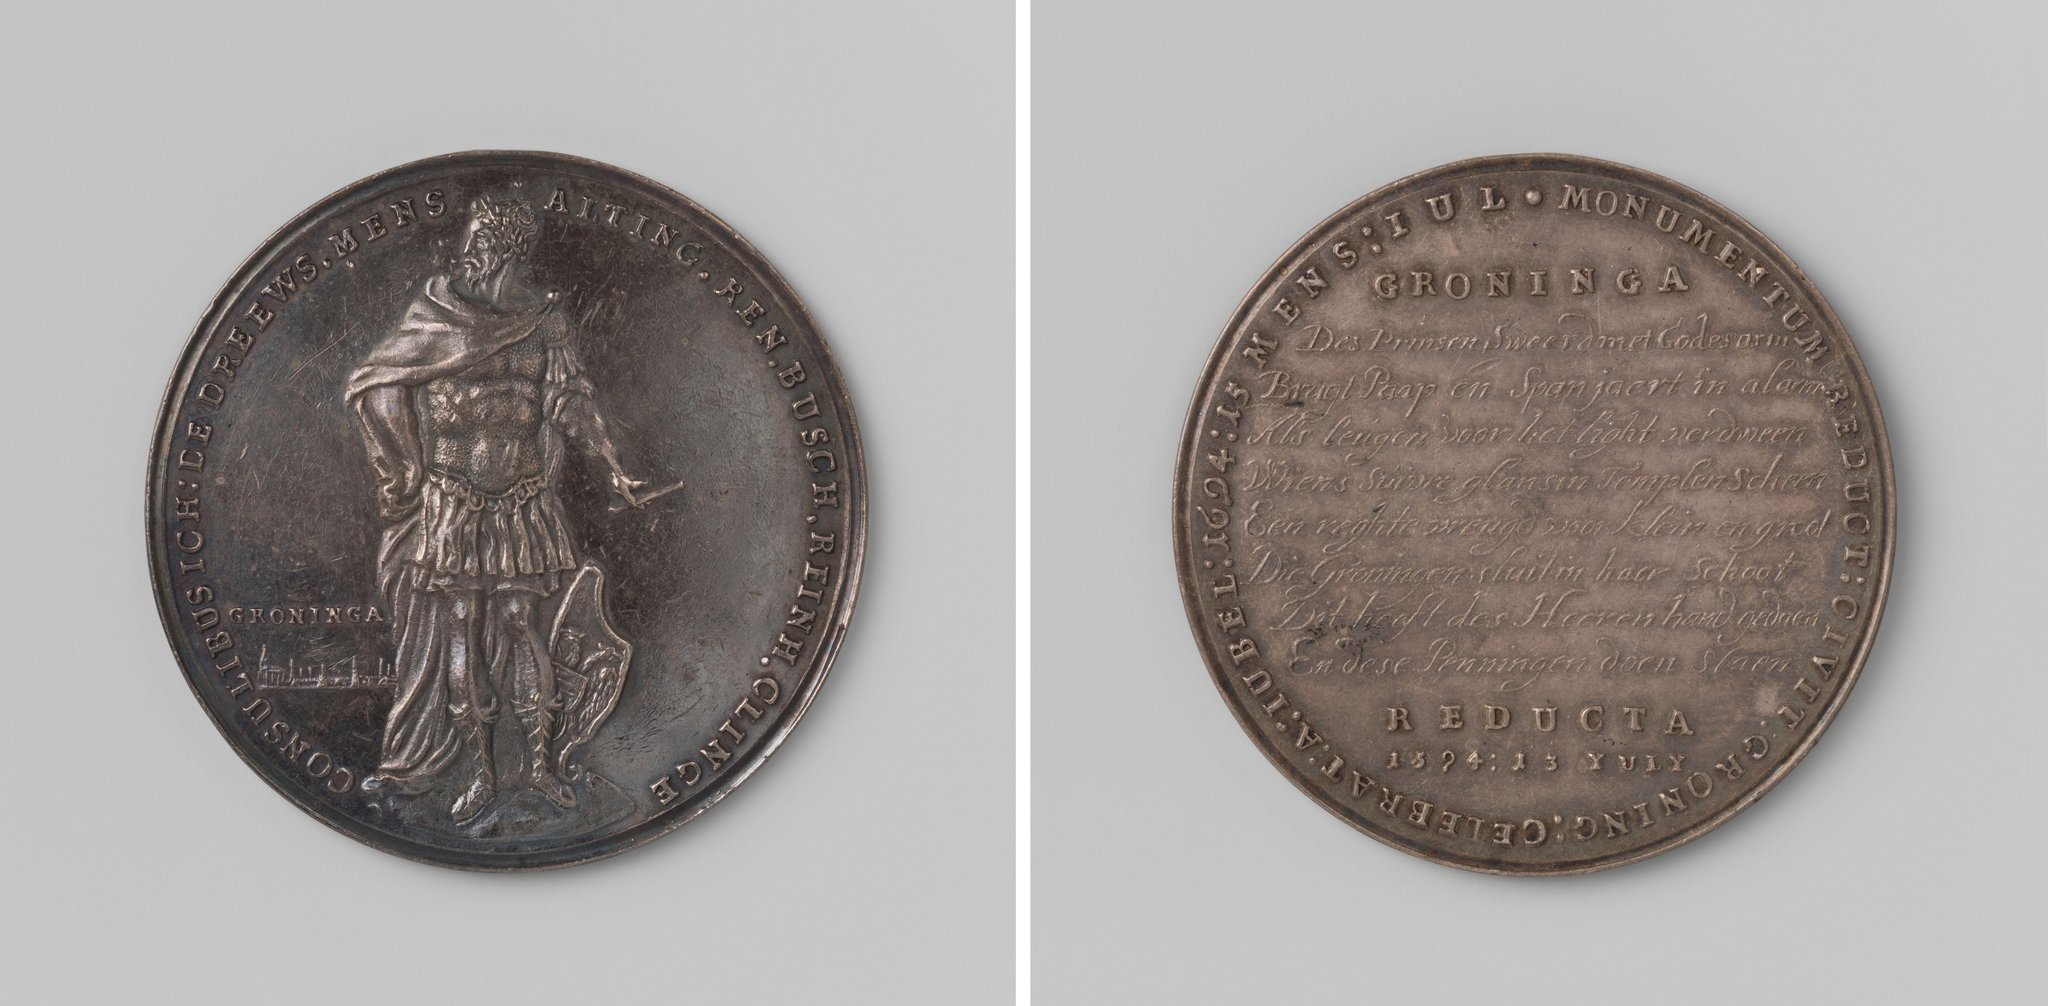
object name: history medal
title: Herdenking van de bevrijding van Groningen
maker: Anonymous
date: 1694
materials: silver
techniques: striking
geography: groningen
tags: groningen, reductie van groningen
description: Zilveren penning. Voorzijde: veldheer in Romeinse toga met commandostaf en wapenschild, op achtergrond gezicht op stad binnen omschrift. Keerzijde: opschrift binnen omschrift